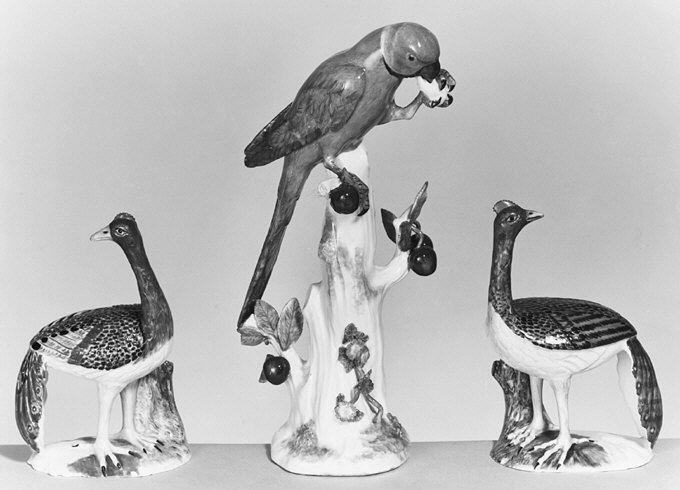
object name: figure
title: Peacock (one of a pair)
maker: meissen manufactory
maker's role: manufactory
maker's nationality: german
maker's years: 1710-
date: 1720-1730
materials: hard paste porcelain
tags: parrots,peacocks